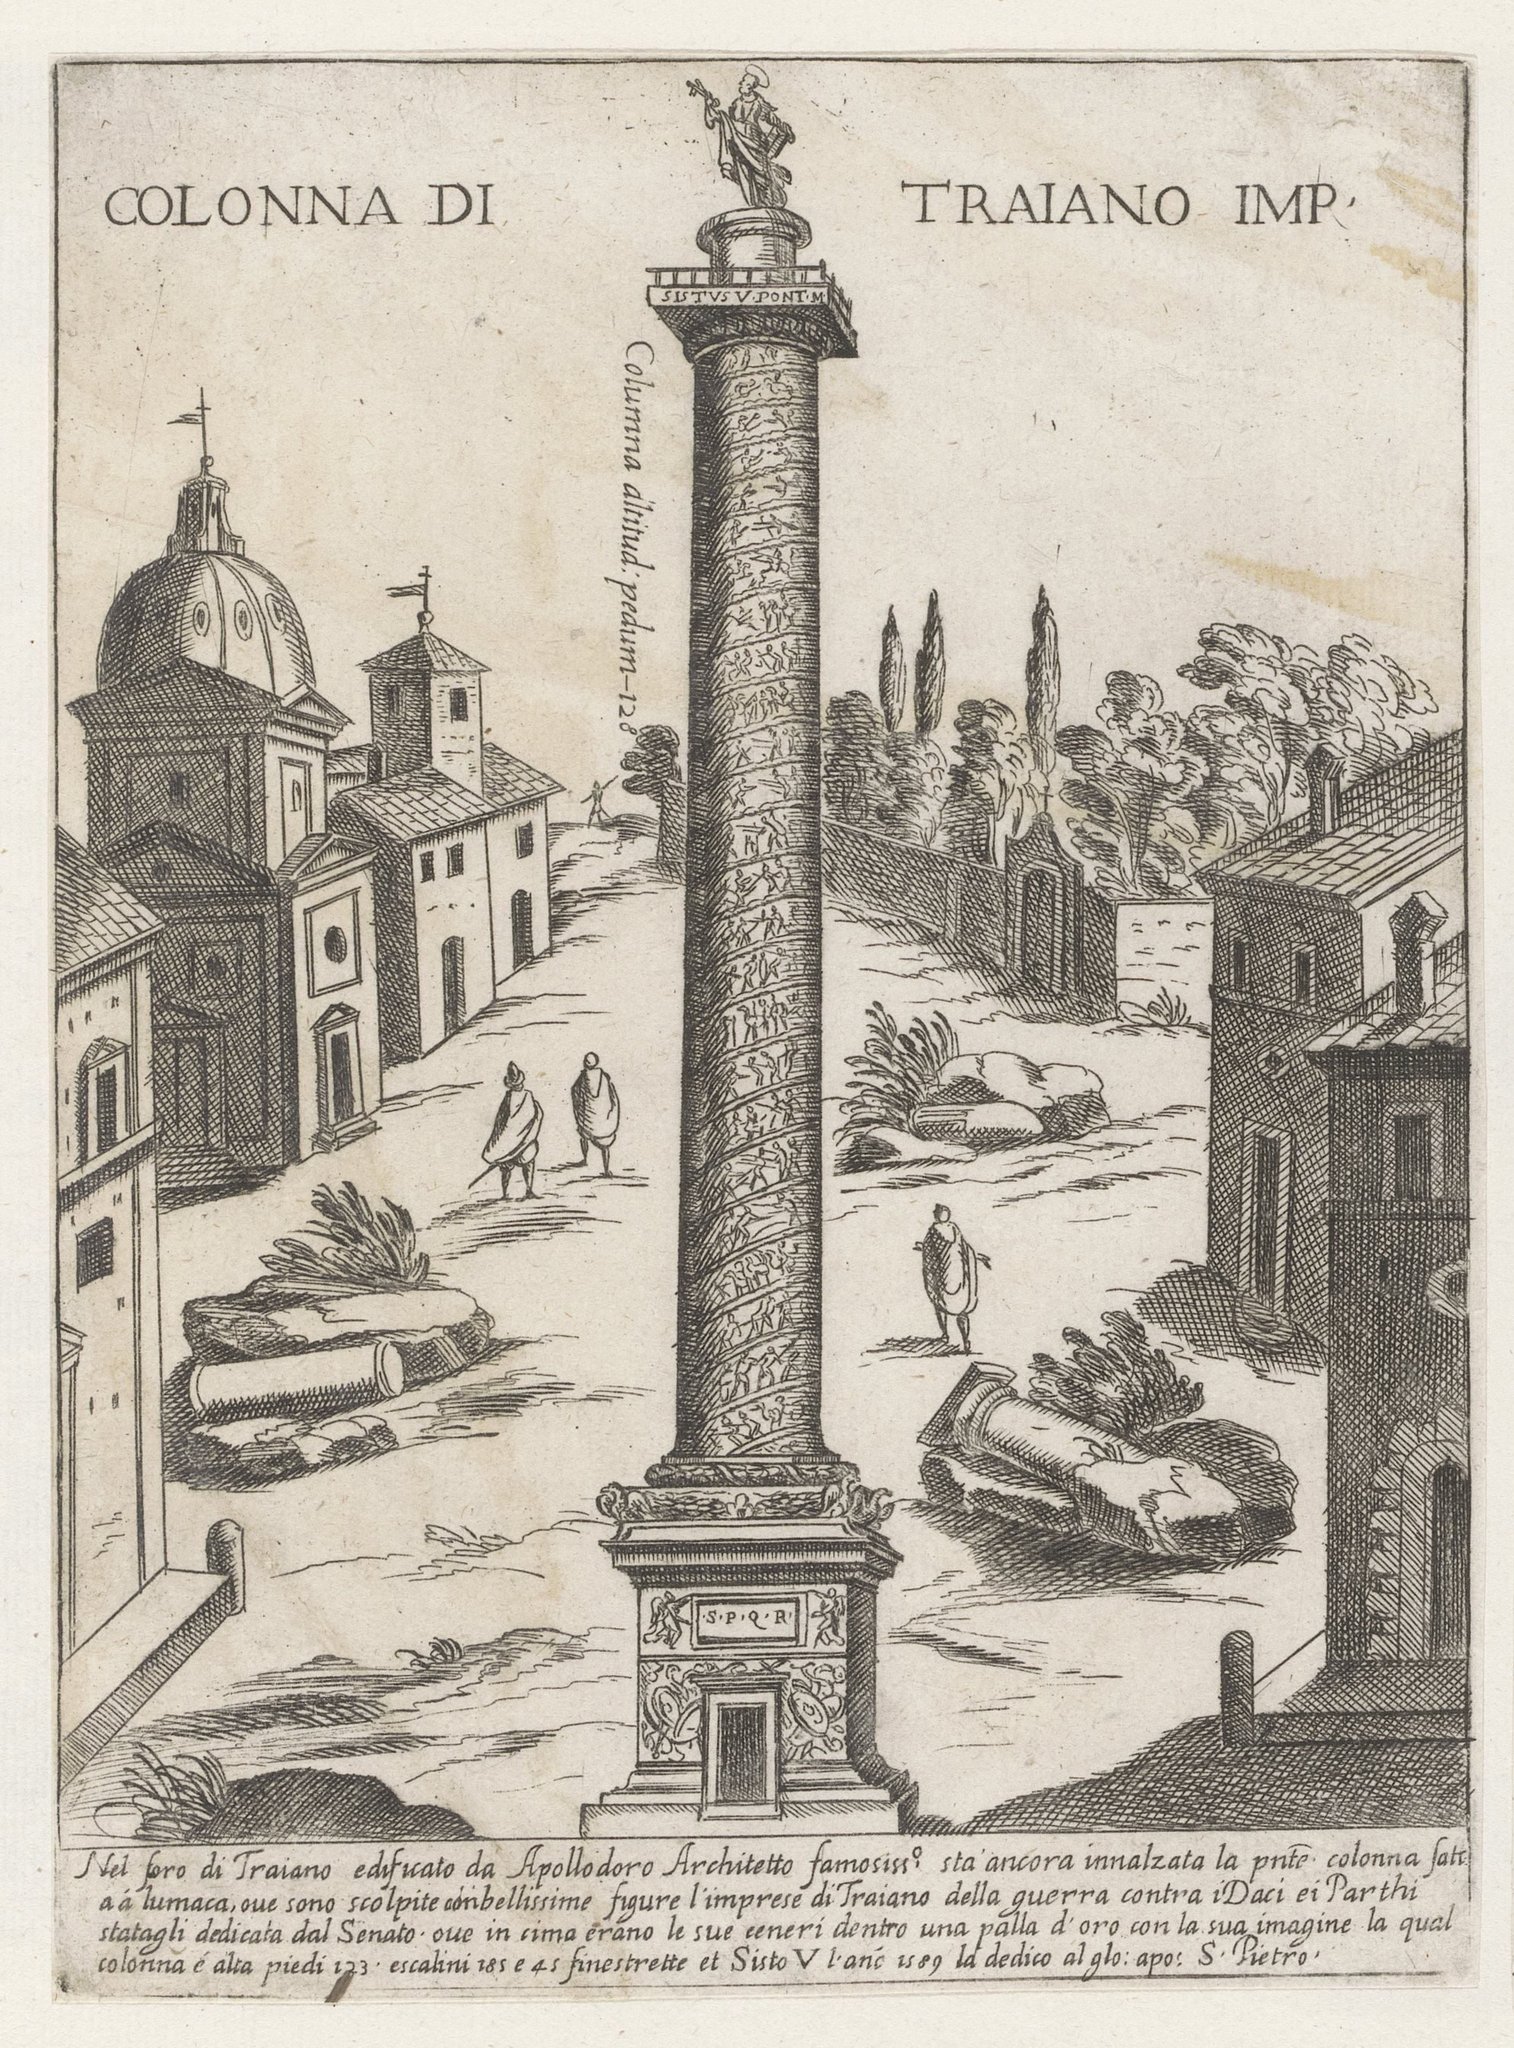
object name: print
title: Nova racolta degl'obelischi et colonne antiche, dellalma Citta di Roma con le sve dichiaratione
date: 1651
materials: paper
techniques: etching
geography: rome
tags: triumphal column with helical friezes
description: Deze prent maakt deel uit van een set prenten (+ titelprent) van zuilen en obelisken in Rome door Giovanni Maggi die is aangevuld met prenten door Louis Rouhier.